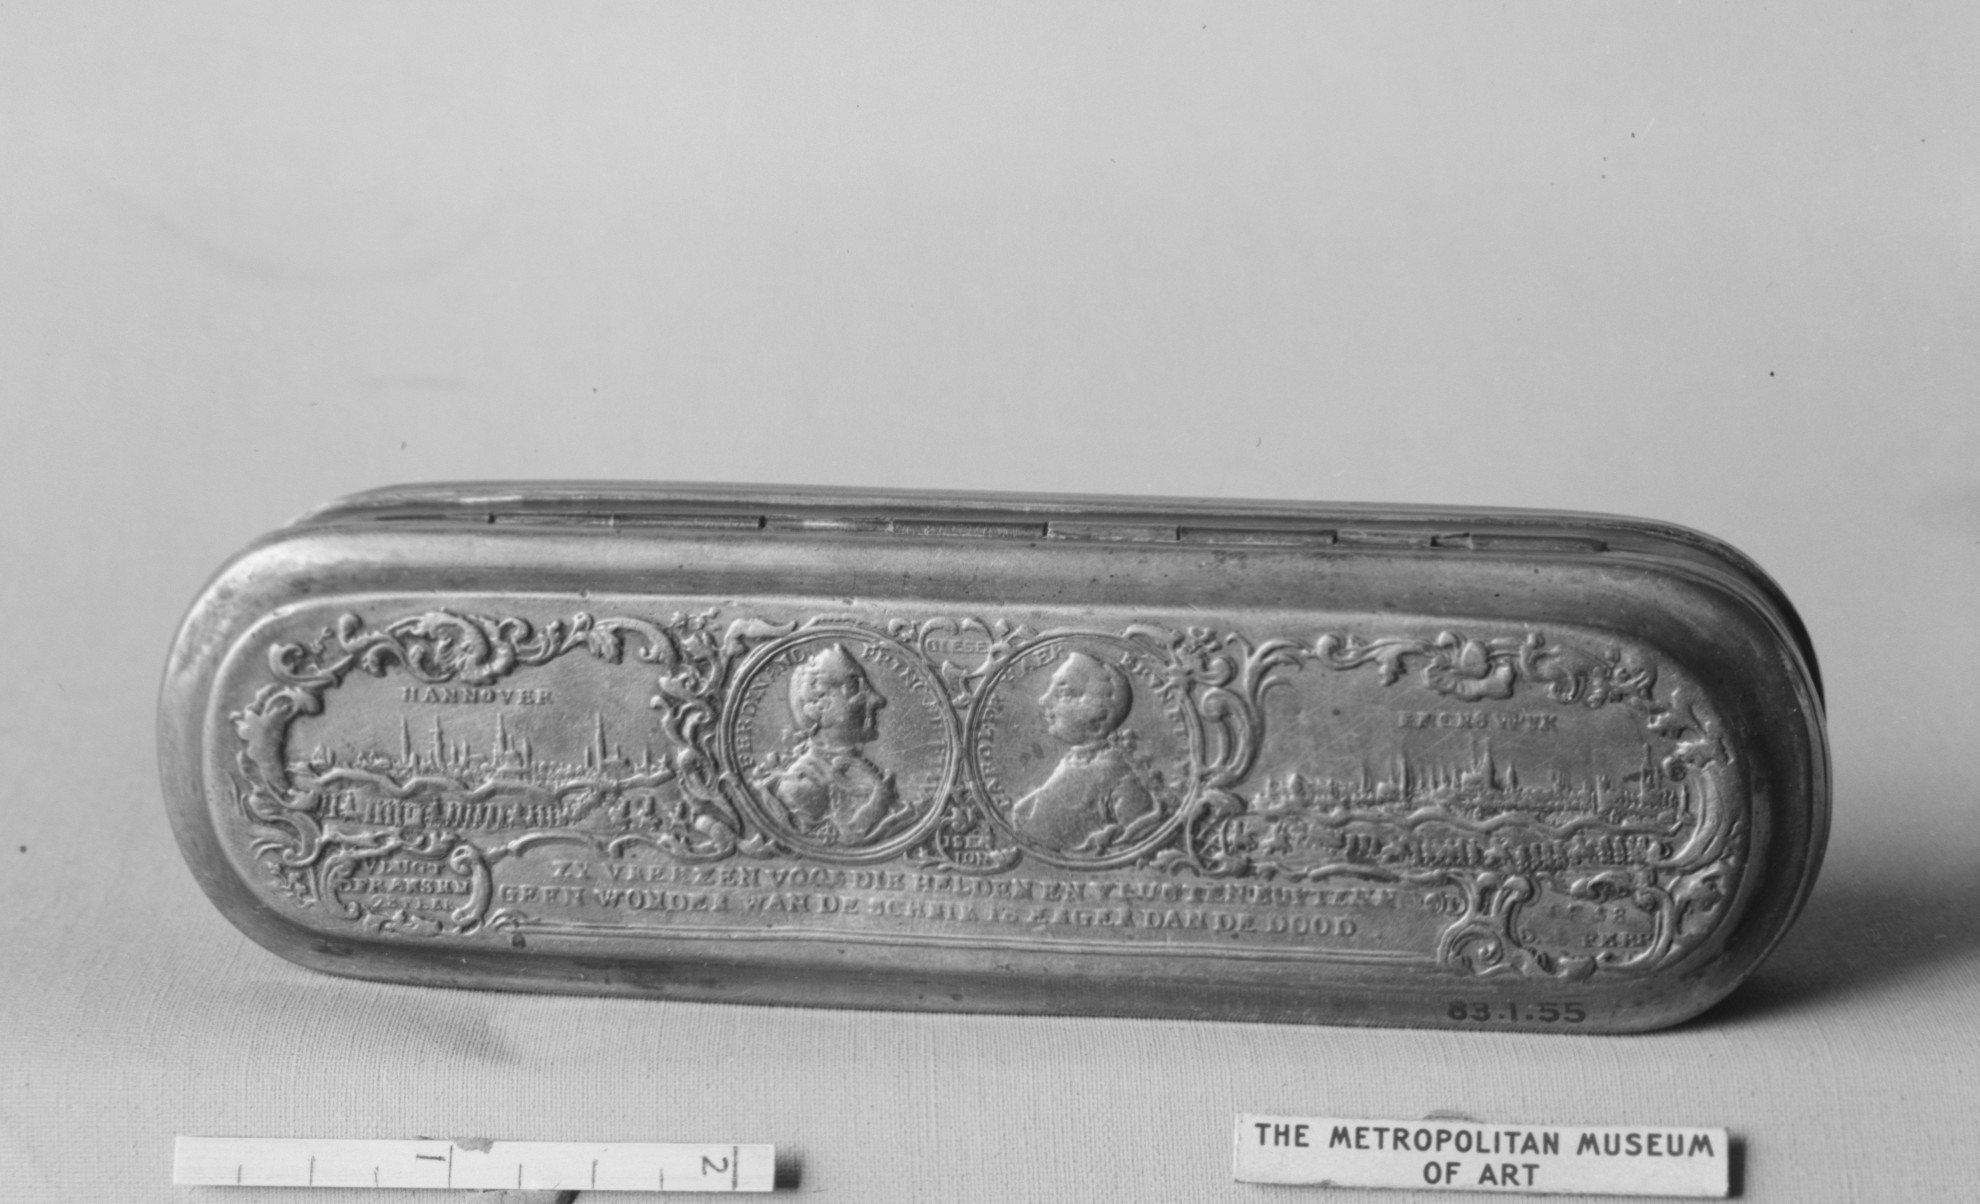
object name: tobacco box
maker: johann heinrich giese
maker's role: maker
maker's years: 1716-1761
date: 1760-1765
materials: brass, copper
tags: men,profiles